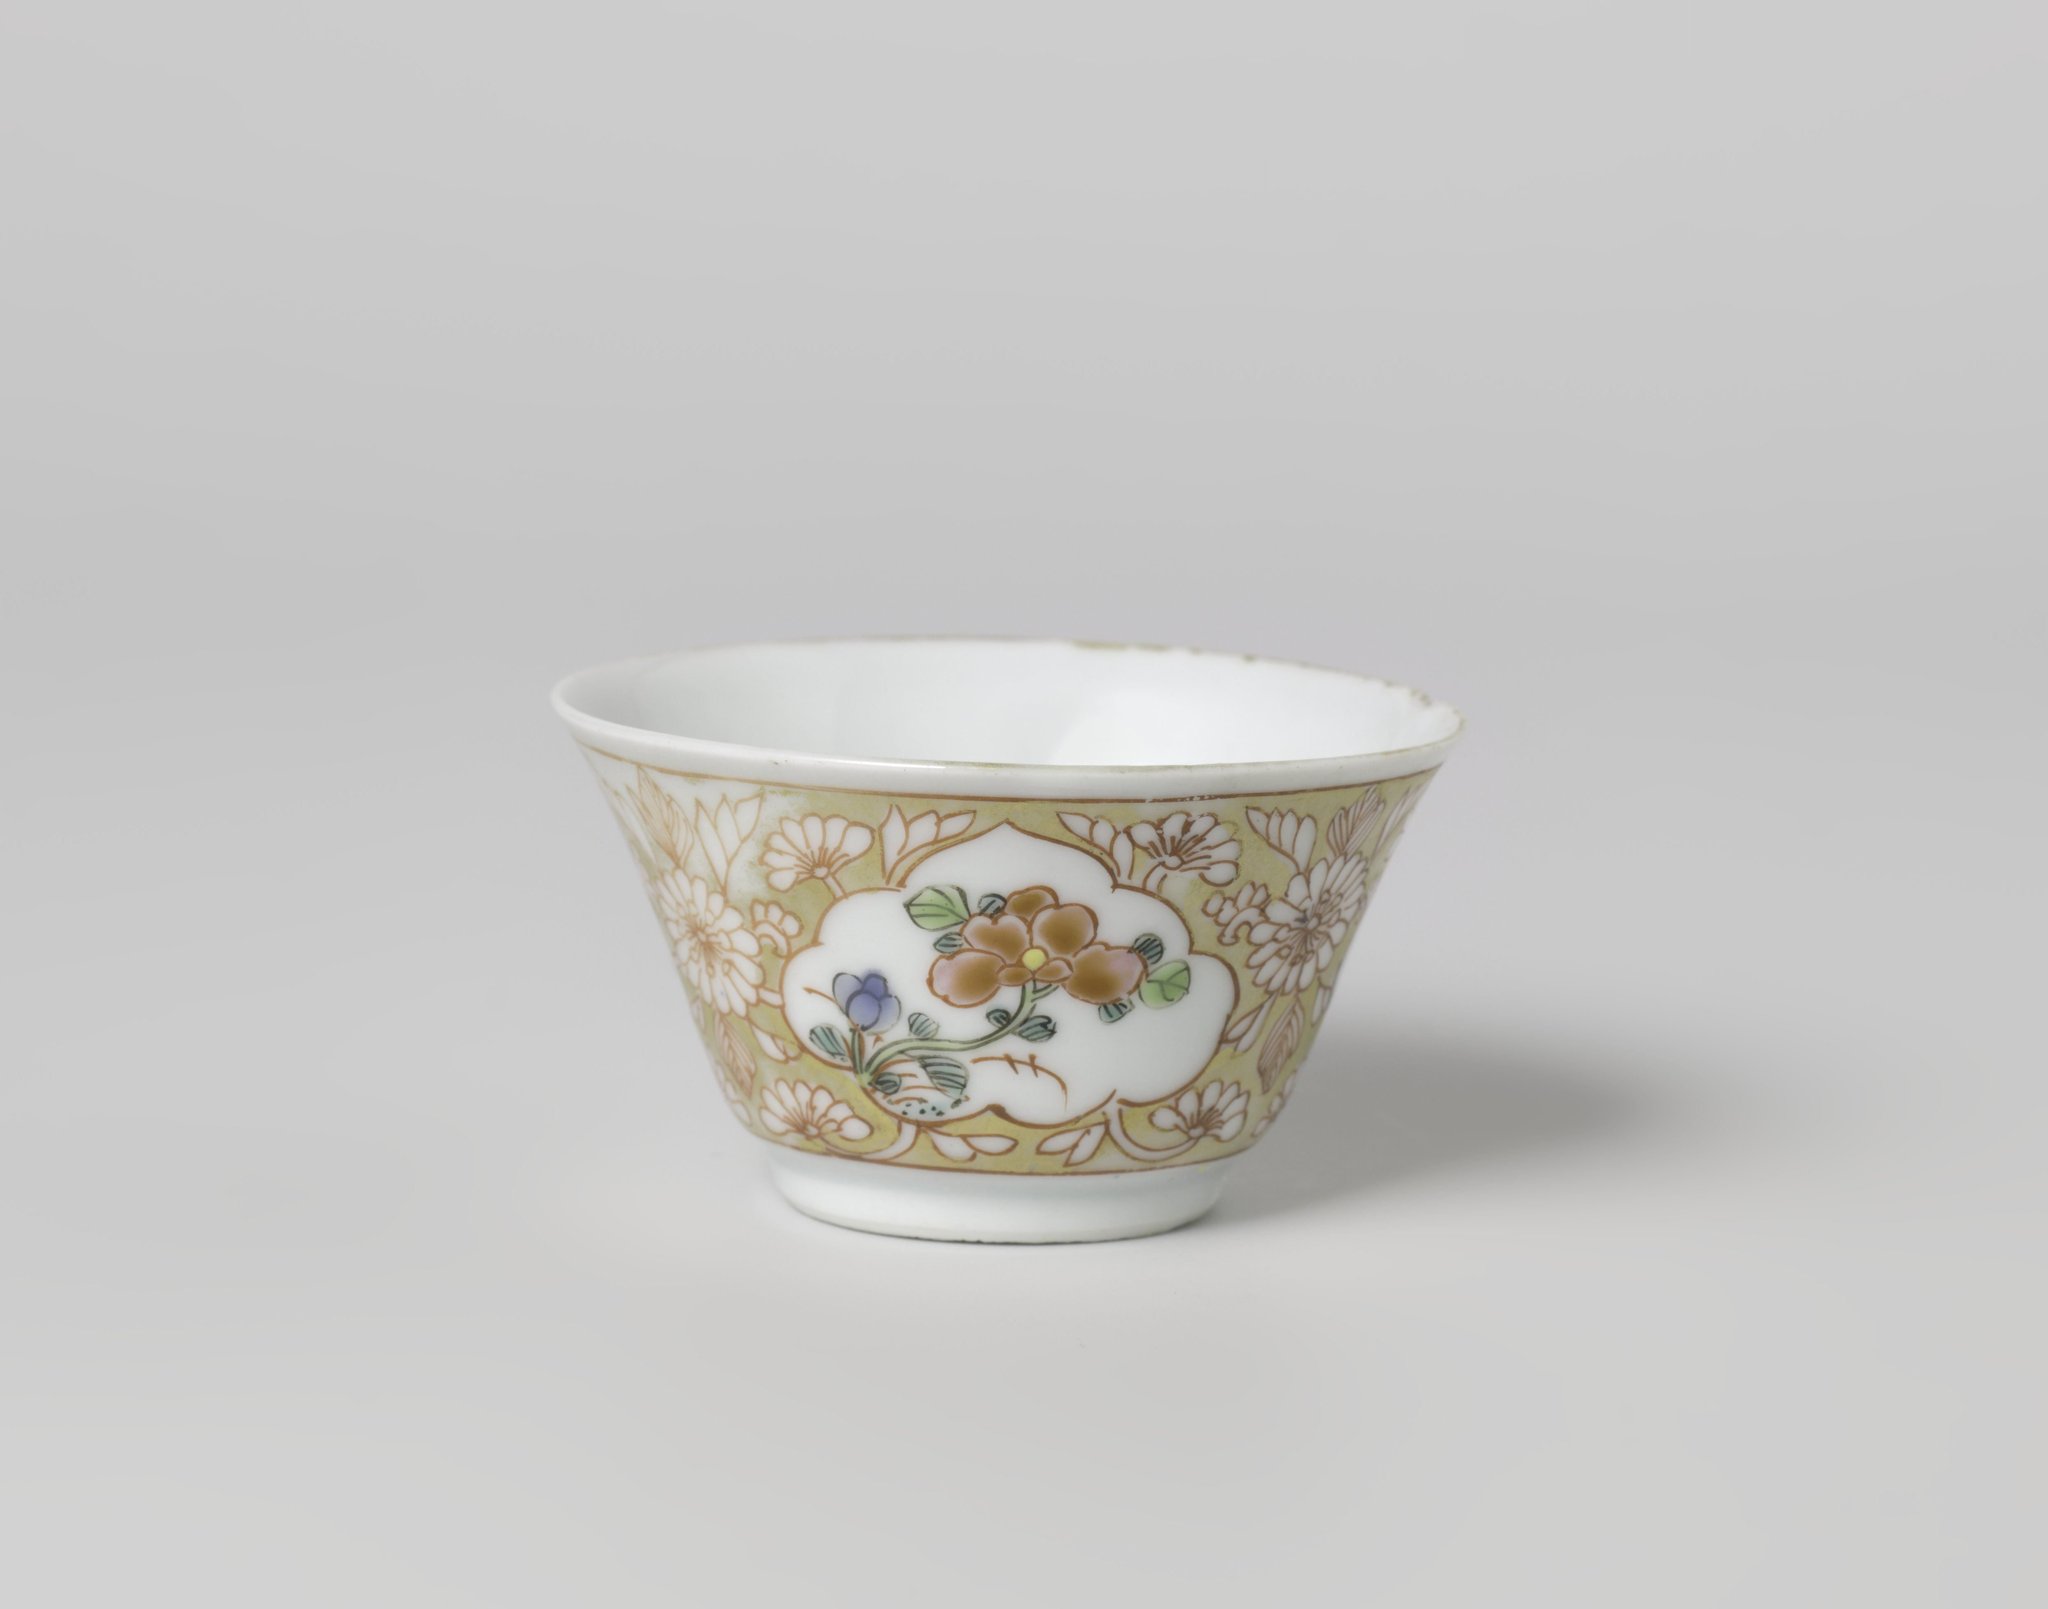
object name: kop en schotel, kop en schotel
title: Cup with a woman with flower basket and flowering plants in panels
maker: Anonymous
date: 1725-1749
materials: glaze, gold, paint, porcelain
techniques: firing, gilding, turning, vitrification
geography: china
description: Kop van porselein met spreidende wand, beschilderd op het glazuur in blauw, rood, roze, groen, zwart en goud. Een medaillon met een vrouw in een landschap met een bloemenmand afgebeeld; om het medaillon uitgespaarde bloemranken en drie cartouches met bloeiende planten (o.a. lotus) in een gouden grond. Een chip in de rand van de kop. Famille rose.